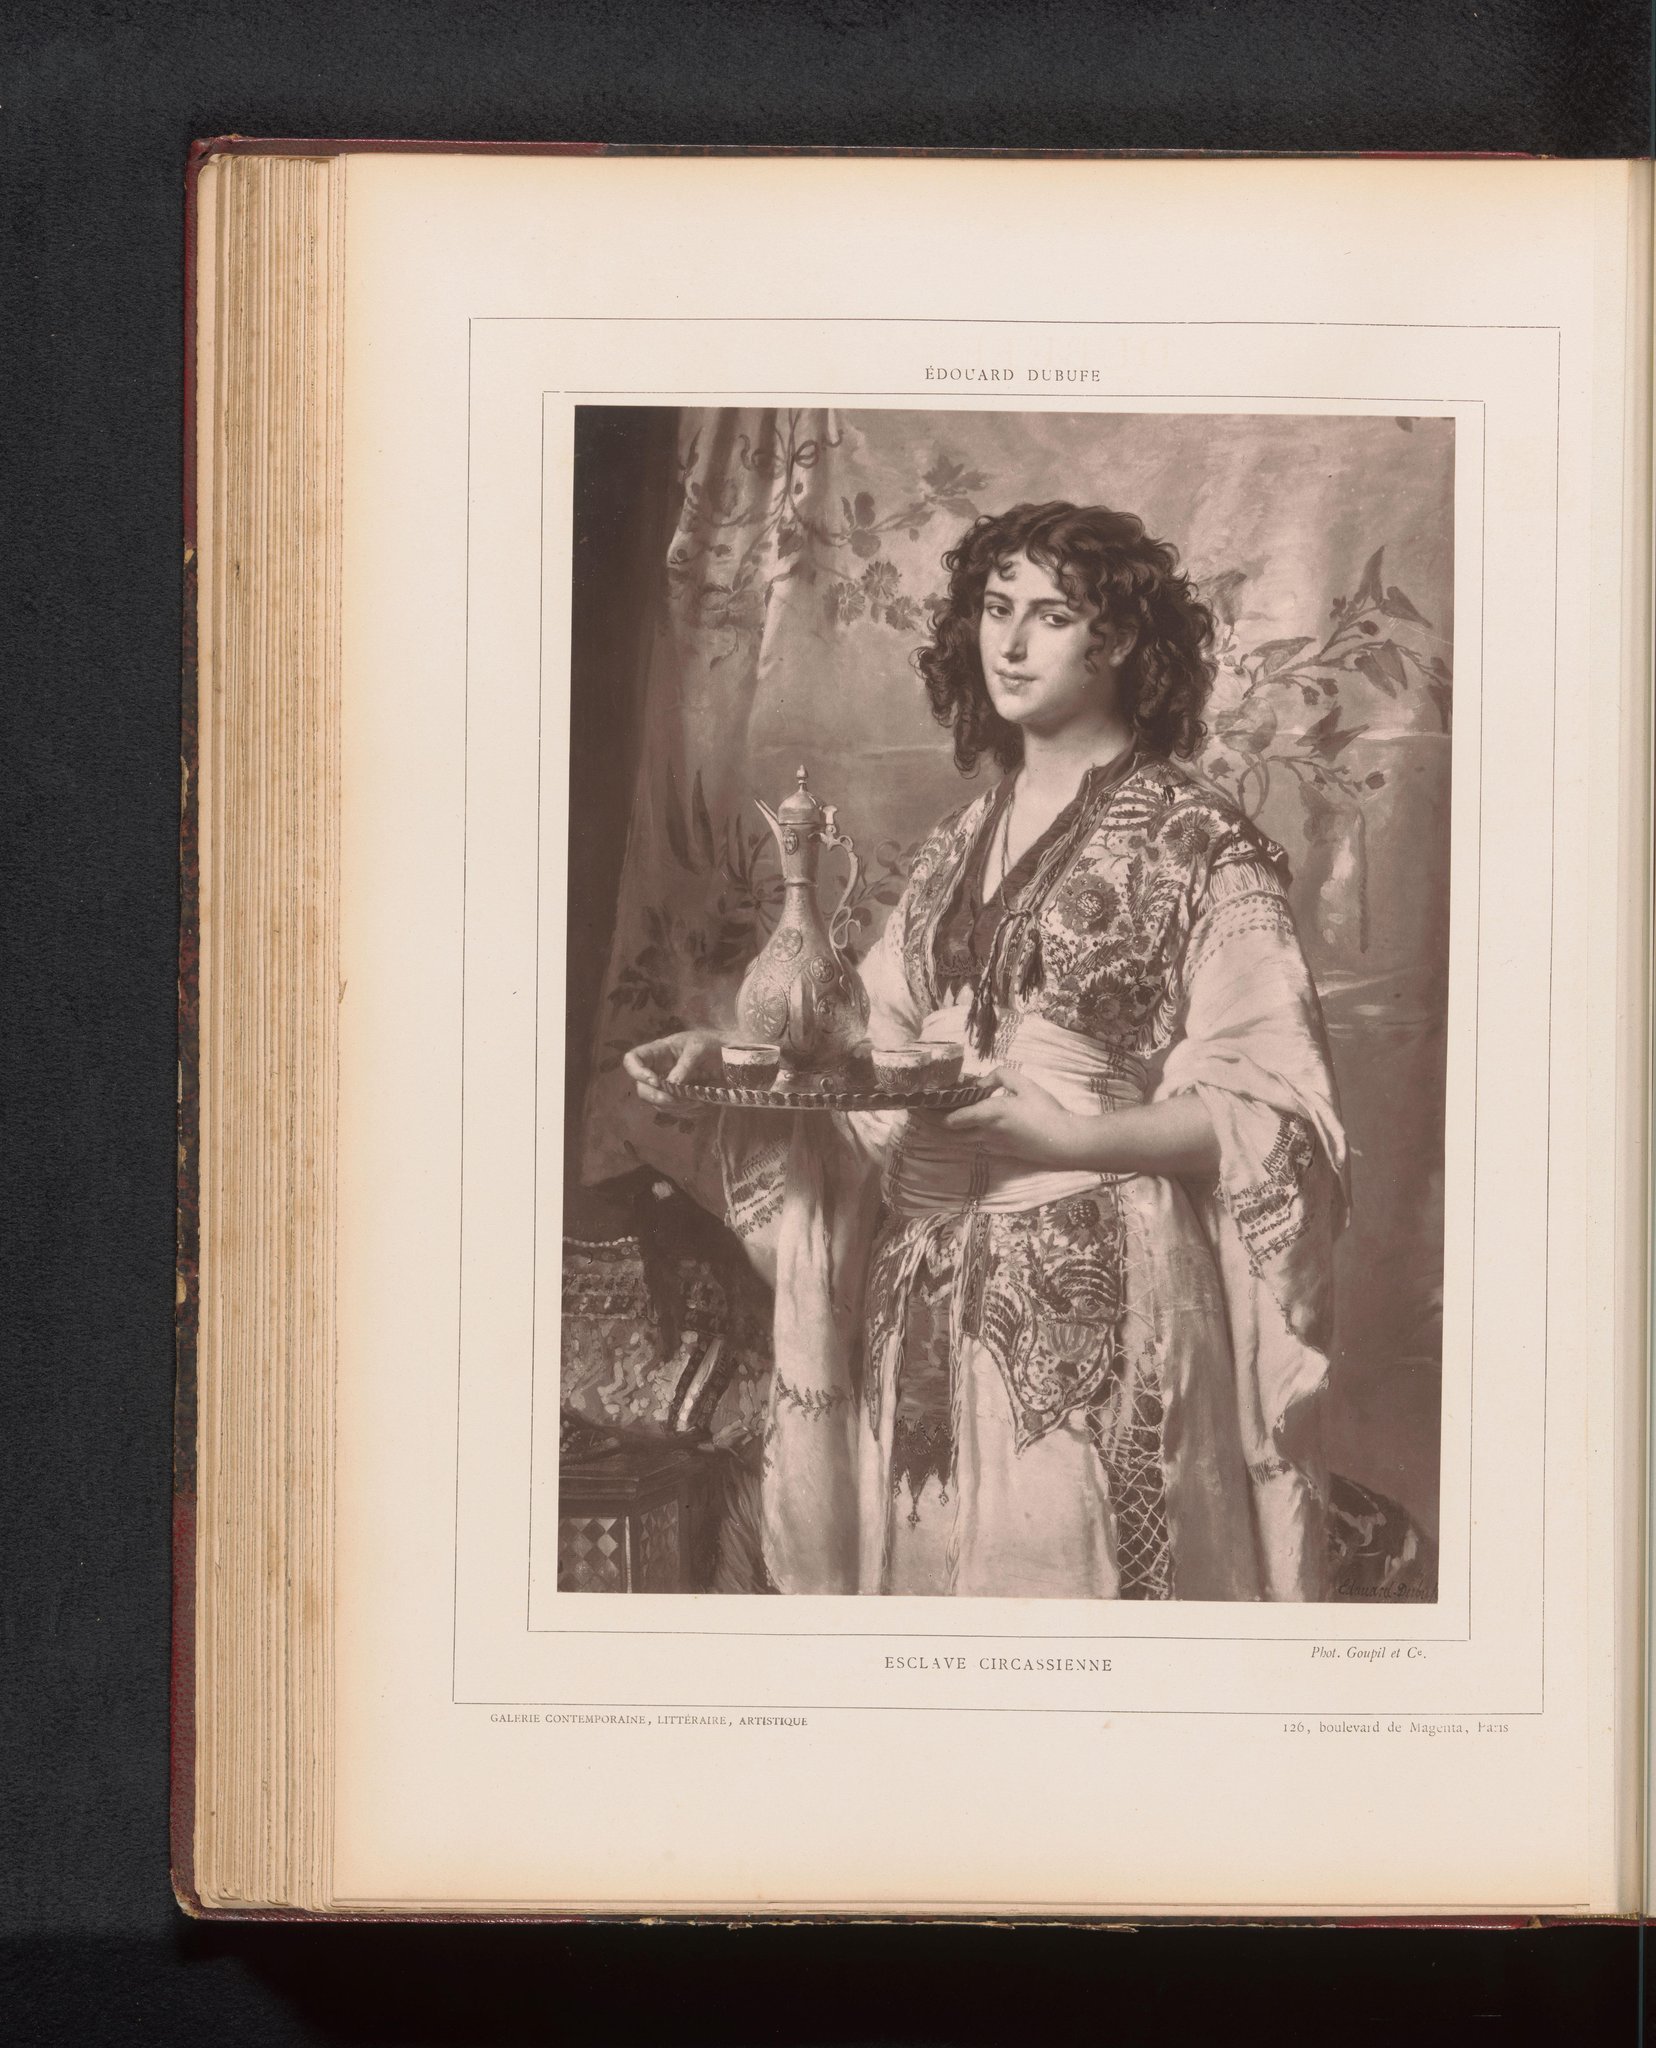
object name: photomechanical print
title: Reproductie van Esclave Circassienne door Edouard Louis Dubufe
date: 1872-1877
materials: paper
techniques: woodburytype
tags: adult woman, painting, drawing and the graphic arts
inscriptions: inscription: ‘E. Dubufe/ Galerie Contemporaine, Littéraire, Artistique/ 126, boulevard de Magenta, Paris’